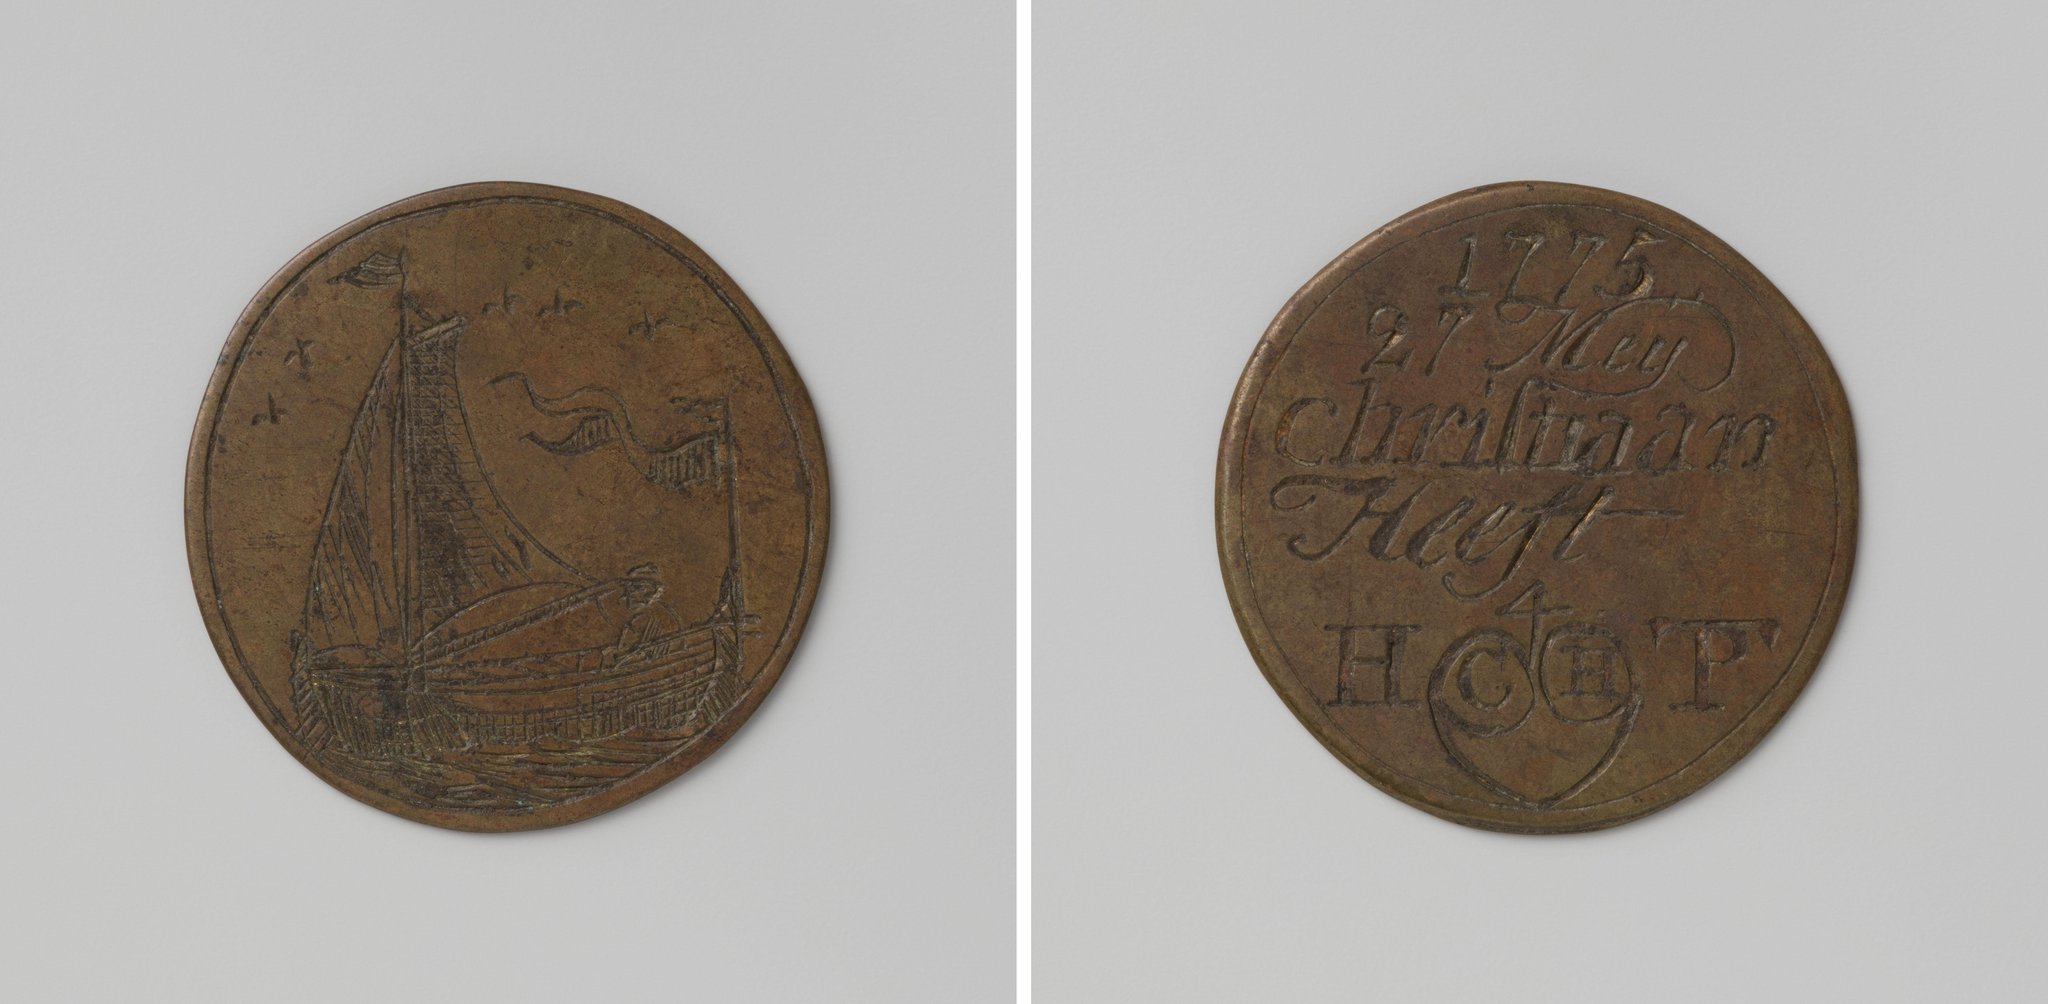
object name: medal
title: Roei-, steiger- en schuitenvoerdersgilde van Amsterdam, gildepenning van Christiaan Heeft, ligplaats Haringpakkerstoren-steiger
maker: Anonymous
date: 1775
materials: brass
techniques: engraving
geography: amsterdam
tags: amsterdam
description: Messing penning. Voorzijde: naar links varende zeilboot; op achterplecht: zittende man en vlag. Keerzijde: opschrift boven huismerk en hart met daarin letters C en H tussen monogram van letters H, P en T